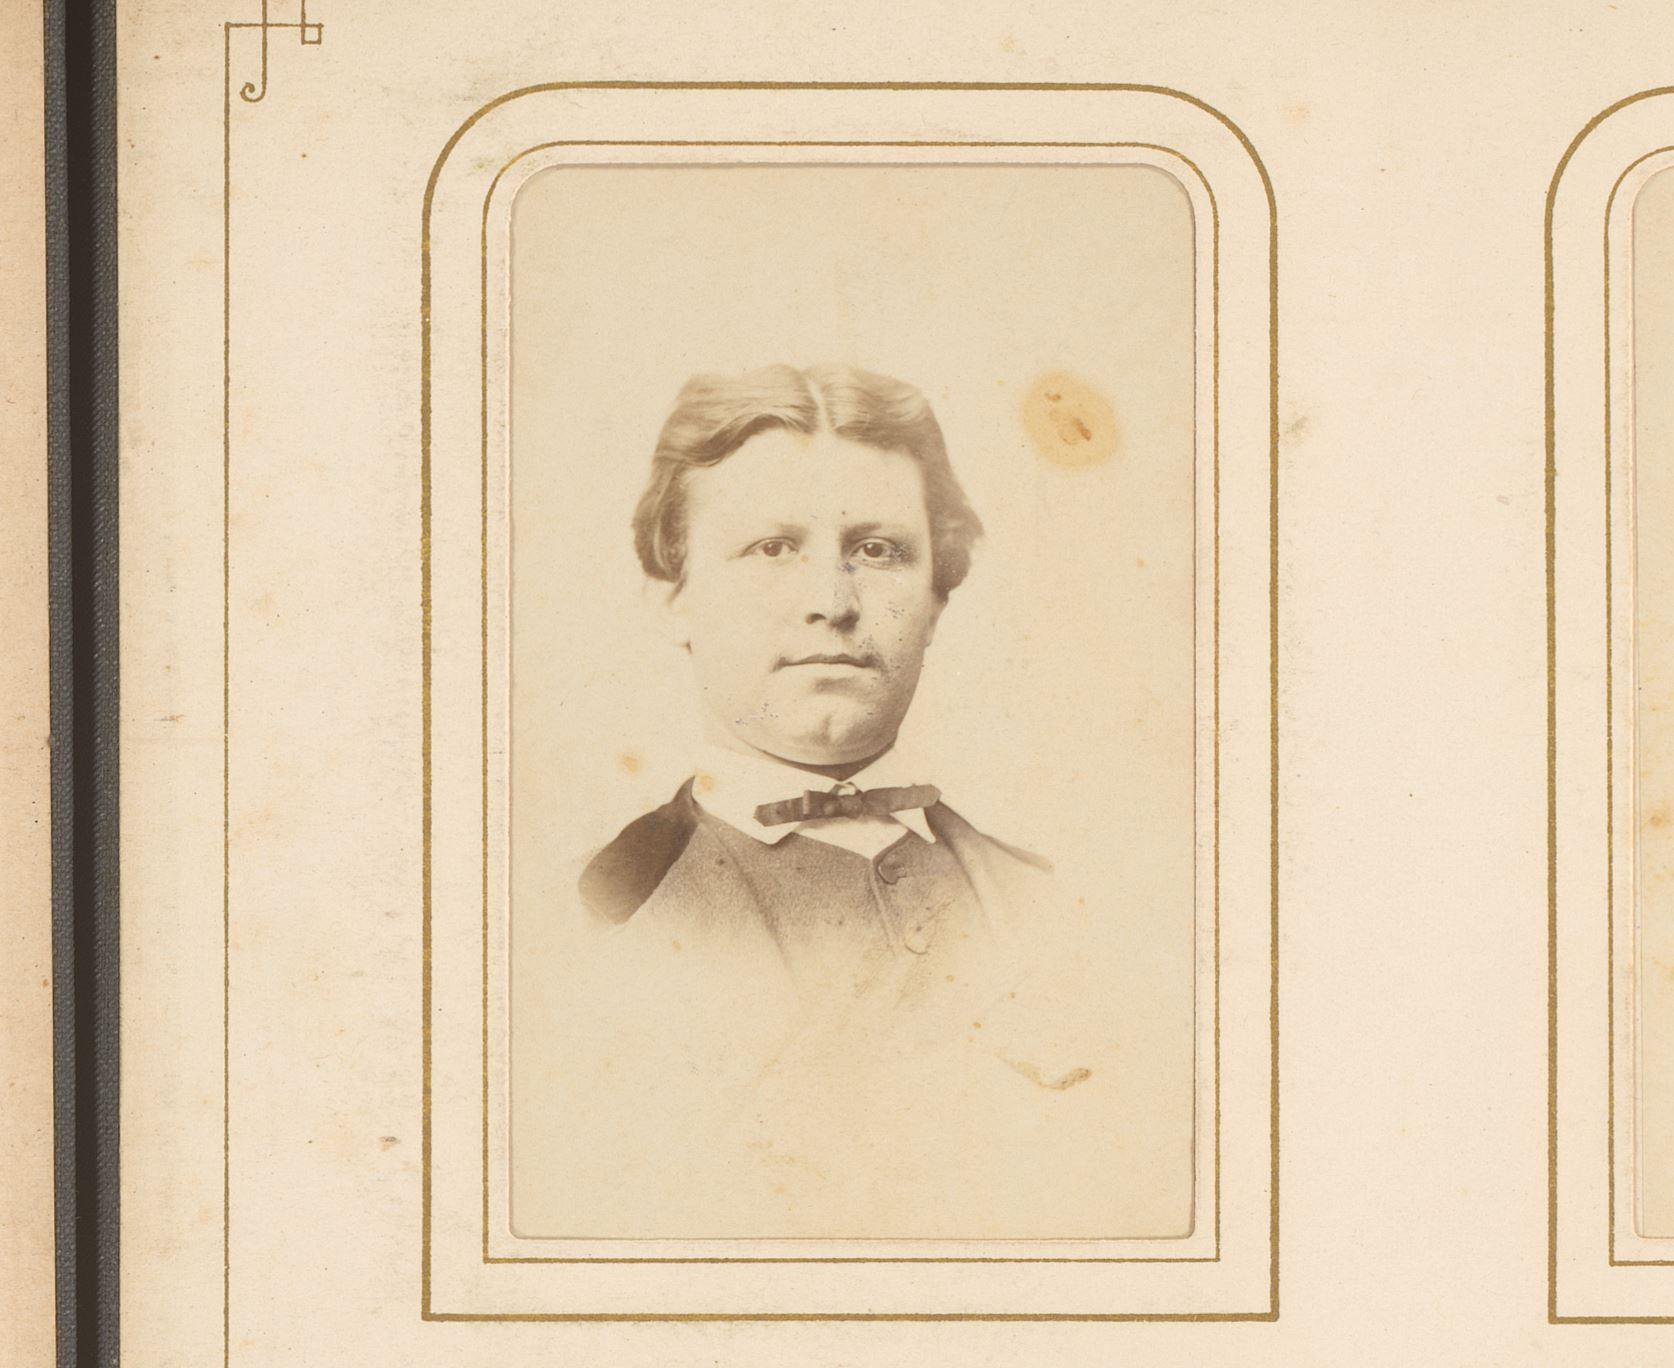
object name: album leaf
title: Portret van een man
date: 1860-1900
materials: cardboard, photographic support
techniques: albumen print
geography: brussels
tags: historical persons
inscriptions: inscription: ‘DECHAMPS & Cie/ PHOTOGRAPHES BREVETÉS,/ 14, Place Ste Gudule, 14,/ BRUXELLES.’